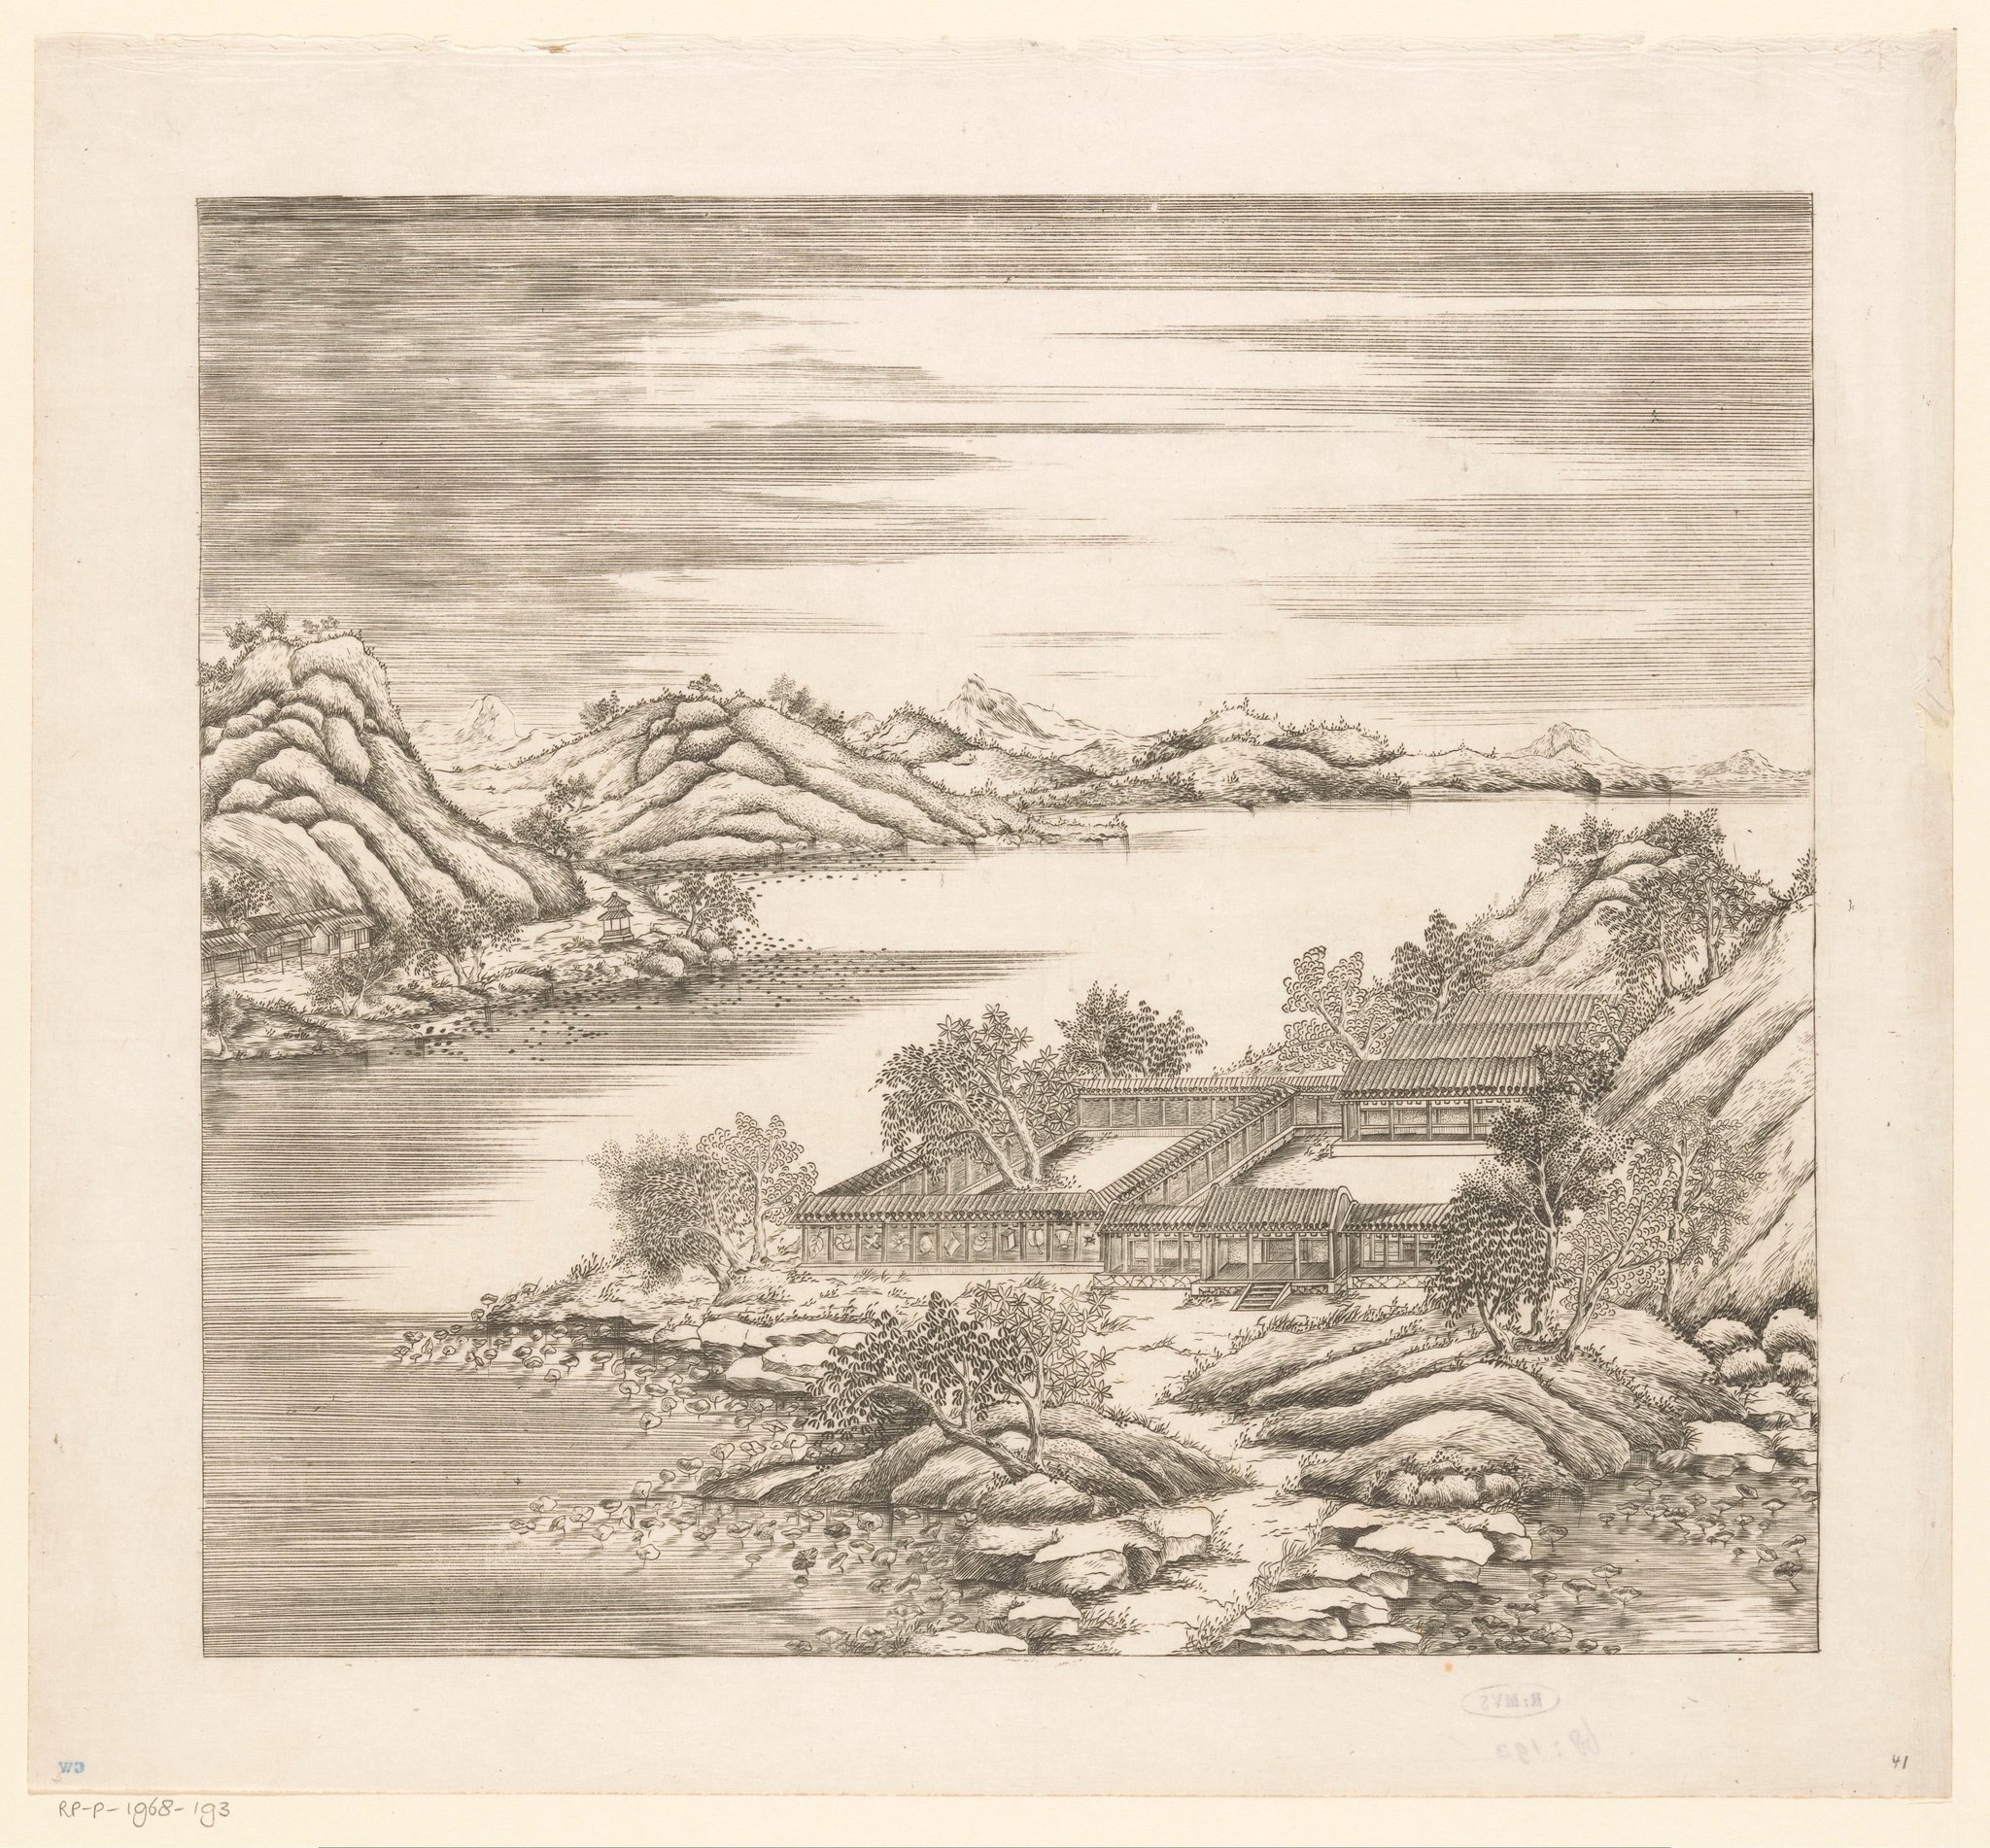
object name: print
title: ‘Un-Summerly Clear and Cool’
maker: matteo ripa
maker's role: priest, print maker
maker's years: 1682-1746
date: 1712-1714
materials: paper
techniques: engraving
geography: china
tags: city-view, and landscape with man-made constructions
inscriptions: collector's mark: Lugt 2228, collector's mark: ‘GW’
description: Emperor Kangxi took up residence in the Summer Palace between April and October each year. He gave names to all 36 locations in the complex, describing them in poetry and prose, and tasked the court painter Shen Yu with translating them into landscape paintings. Kangxi called this site ‘clear and cool’.